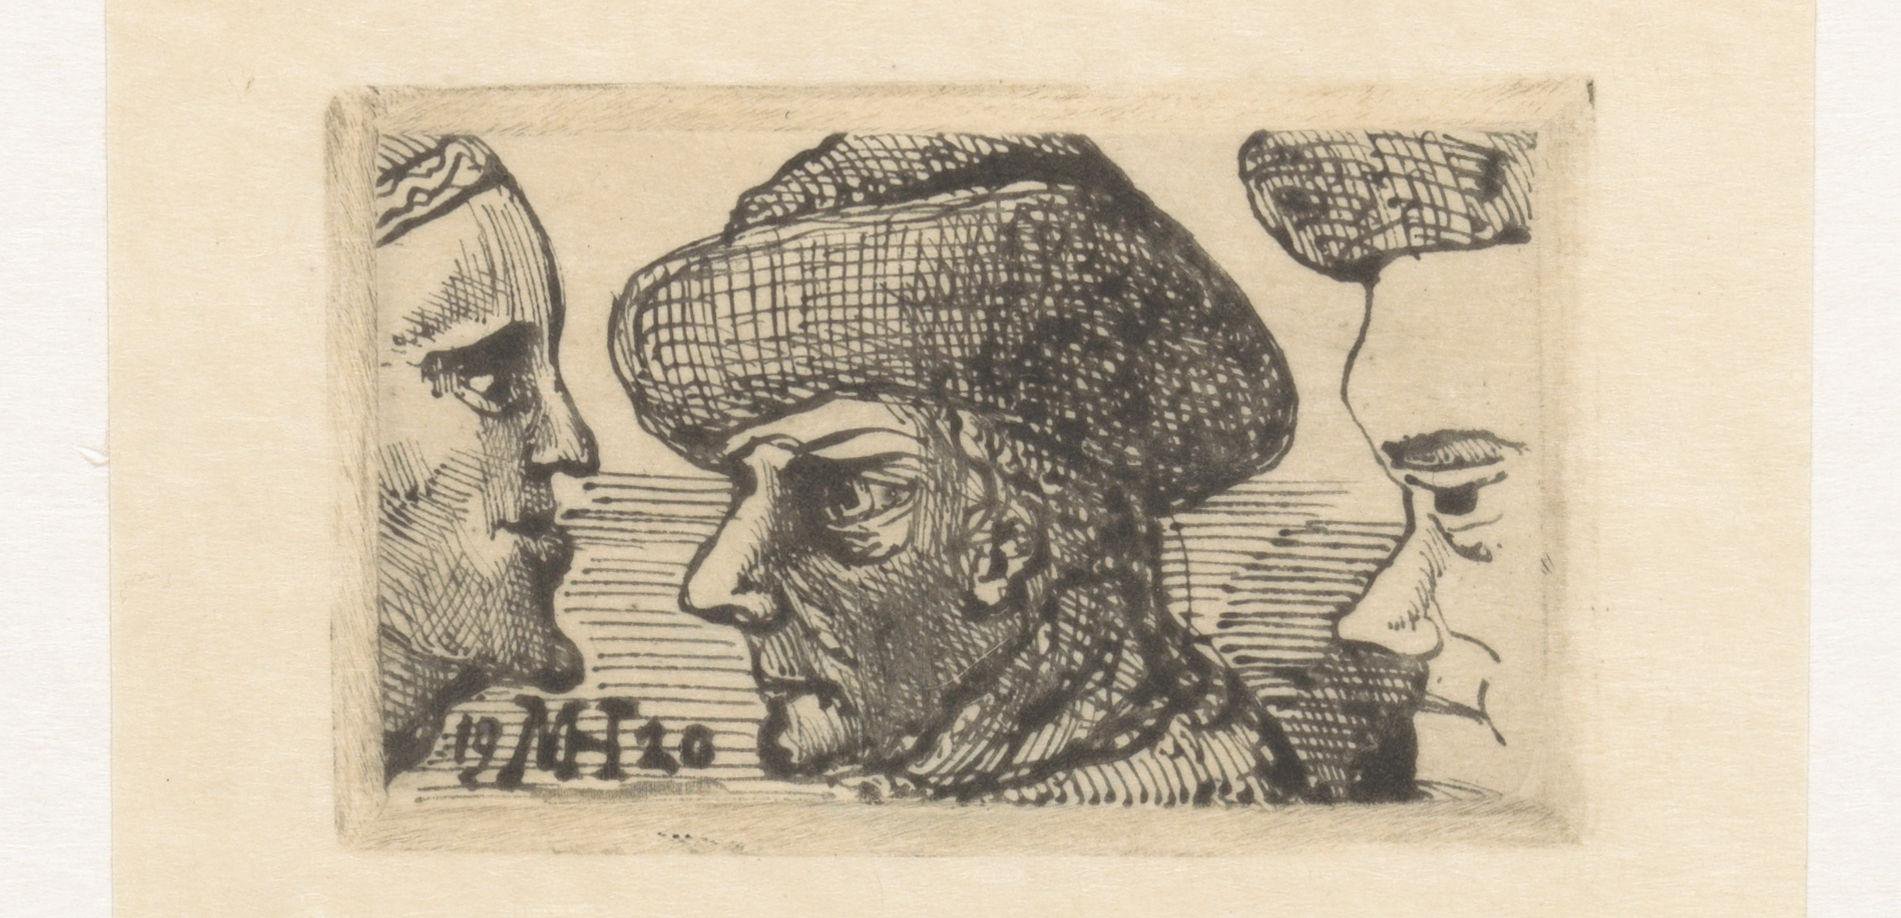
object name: print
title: Drie mannenhoofden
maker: marius holleman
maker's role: draughtsman, print maker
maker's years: 1878-1926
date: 1920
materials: paper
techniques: etching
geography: groningen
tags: adult man, head-gear: hat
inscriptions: collector's mark: Lugt 2228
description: De linker man en profil naar rechts; de twee andere mannen en profil naar links. De middelste man draagt een hoed.